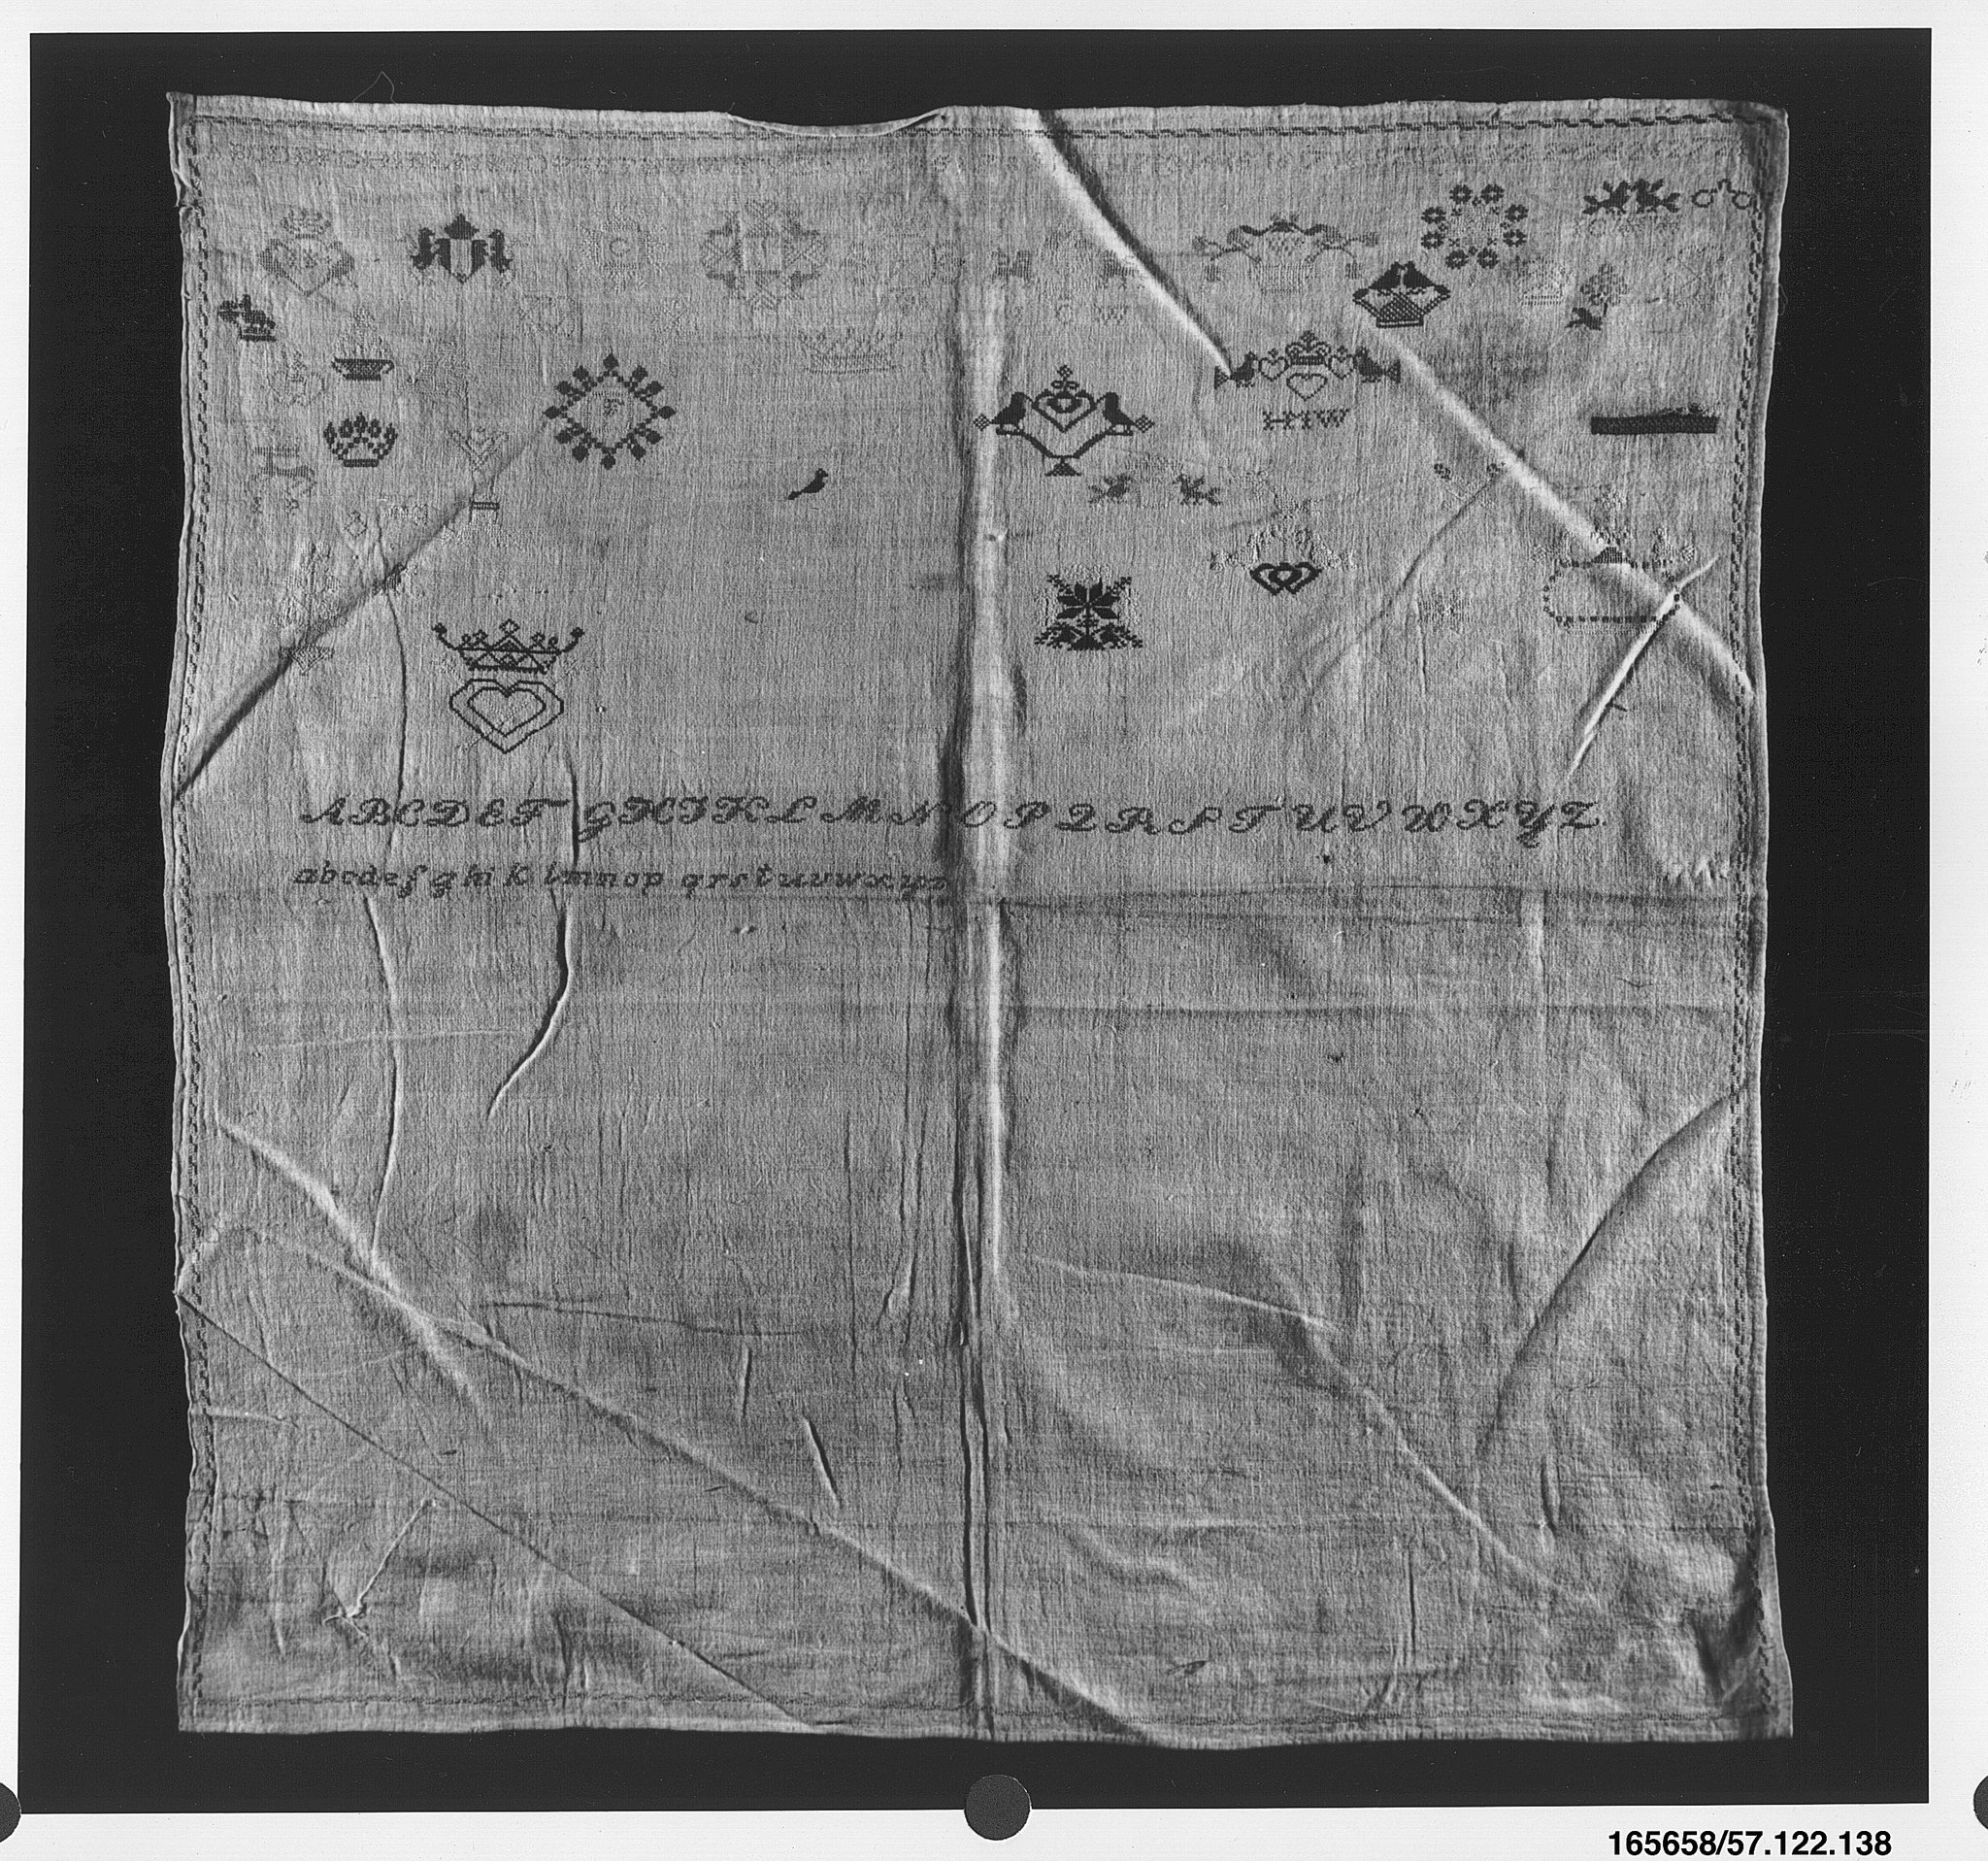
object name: sampler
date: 1701-1800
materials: cotton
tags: flowers